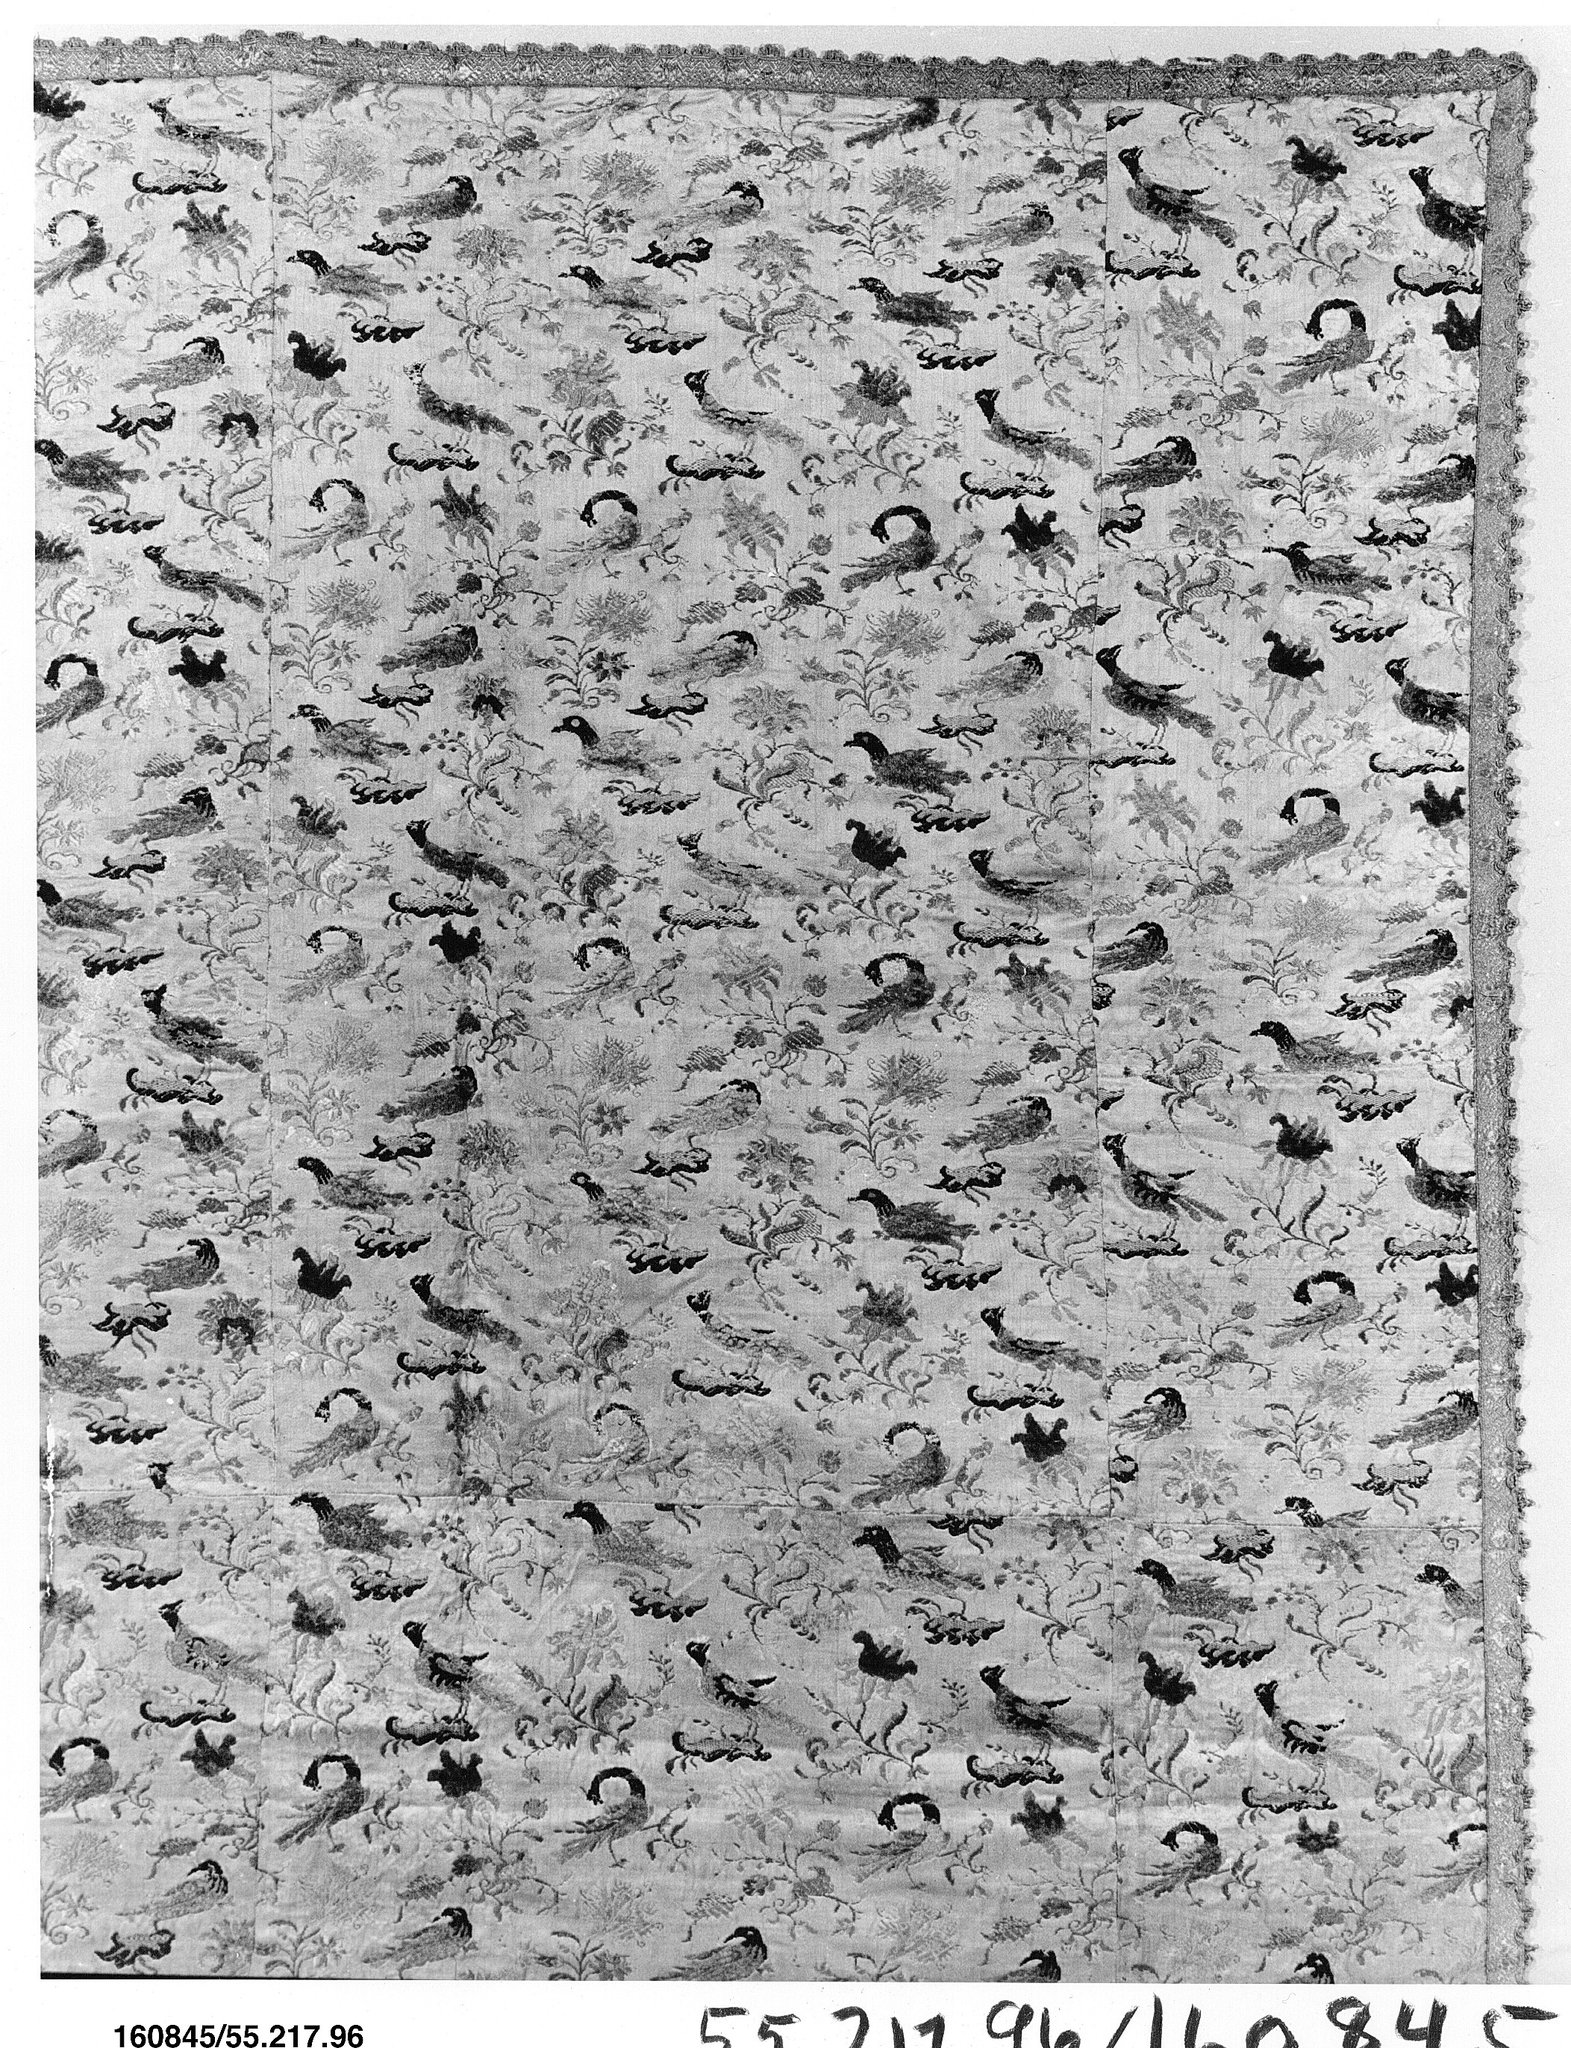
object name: piece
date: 1701-1800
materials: silk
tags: birds,flowers